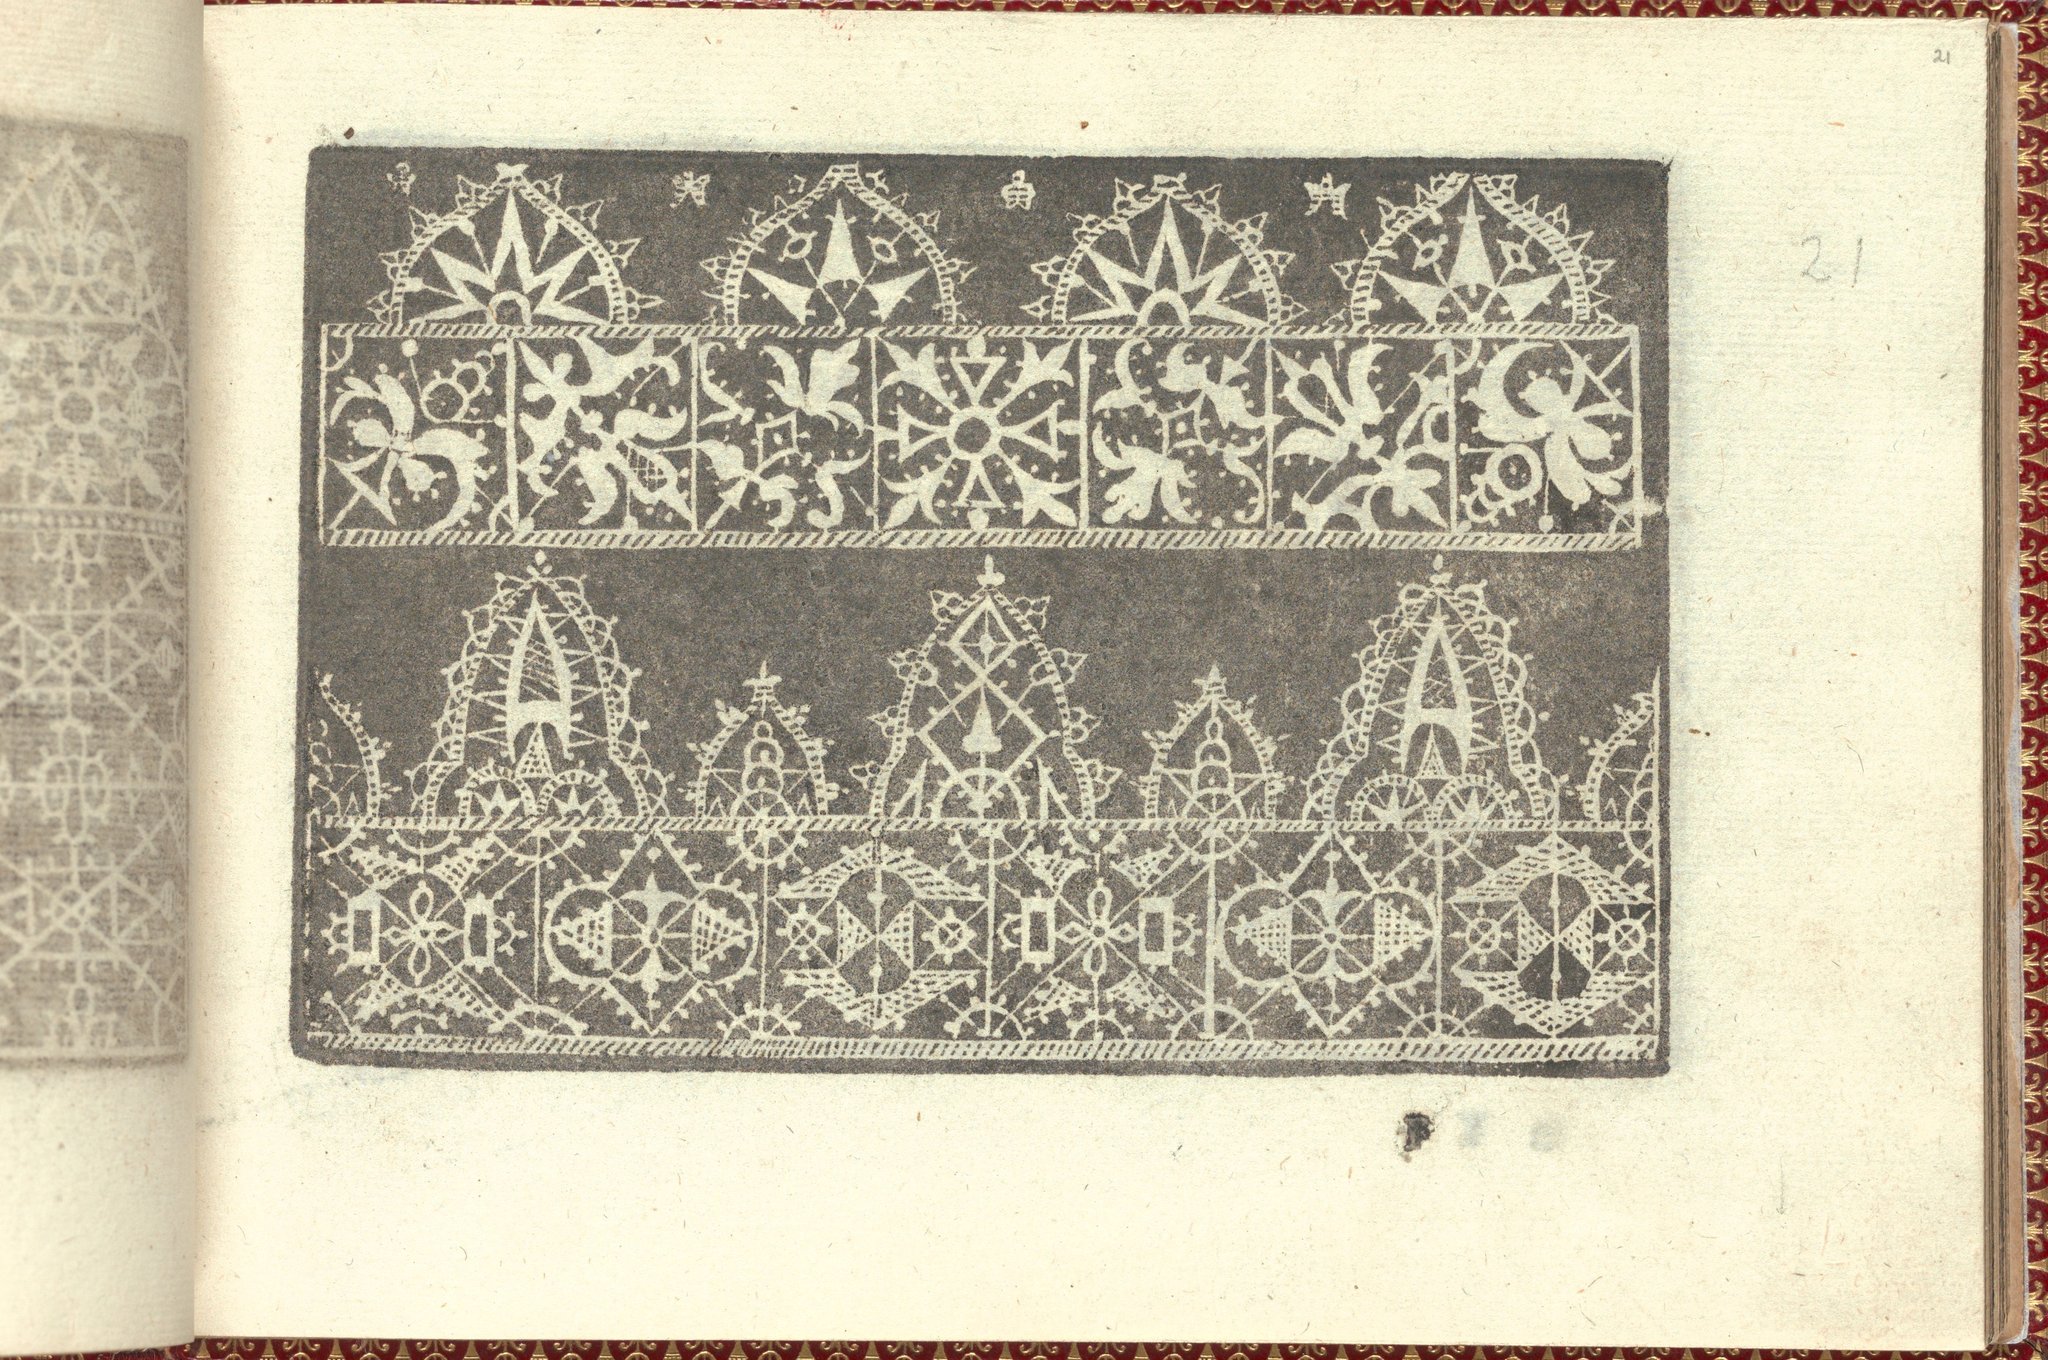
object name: book print ornament architecture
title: Corona delle Nobili et Virtuose Donne: Libro I-IV, page 21 (recto)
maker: cesare vecellio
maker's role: publisher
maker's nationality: italian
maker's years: 1521-1601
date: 1601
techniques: woodcut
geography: italy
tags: flowers